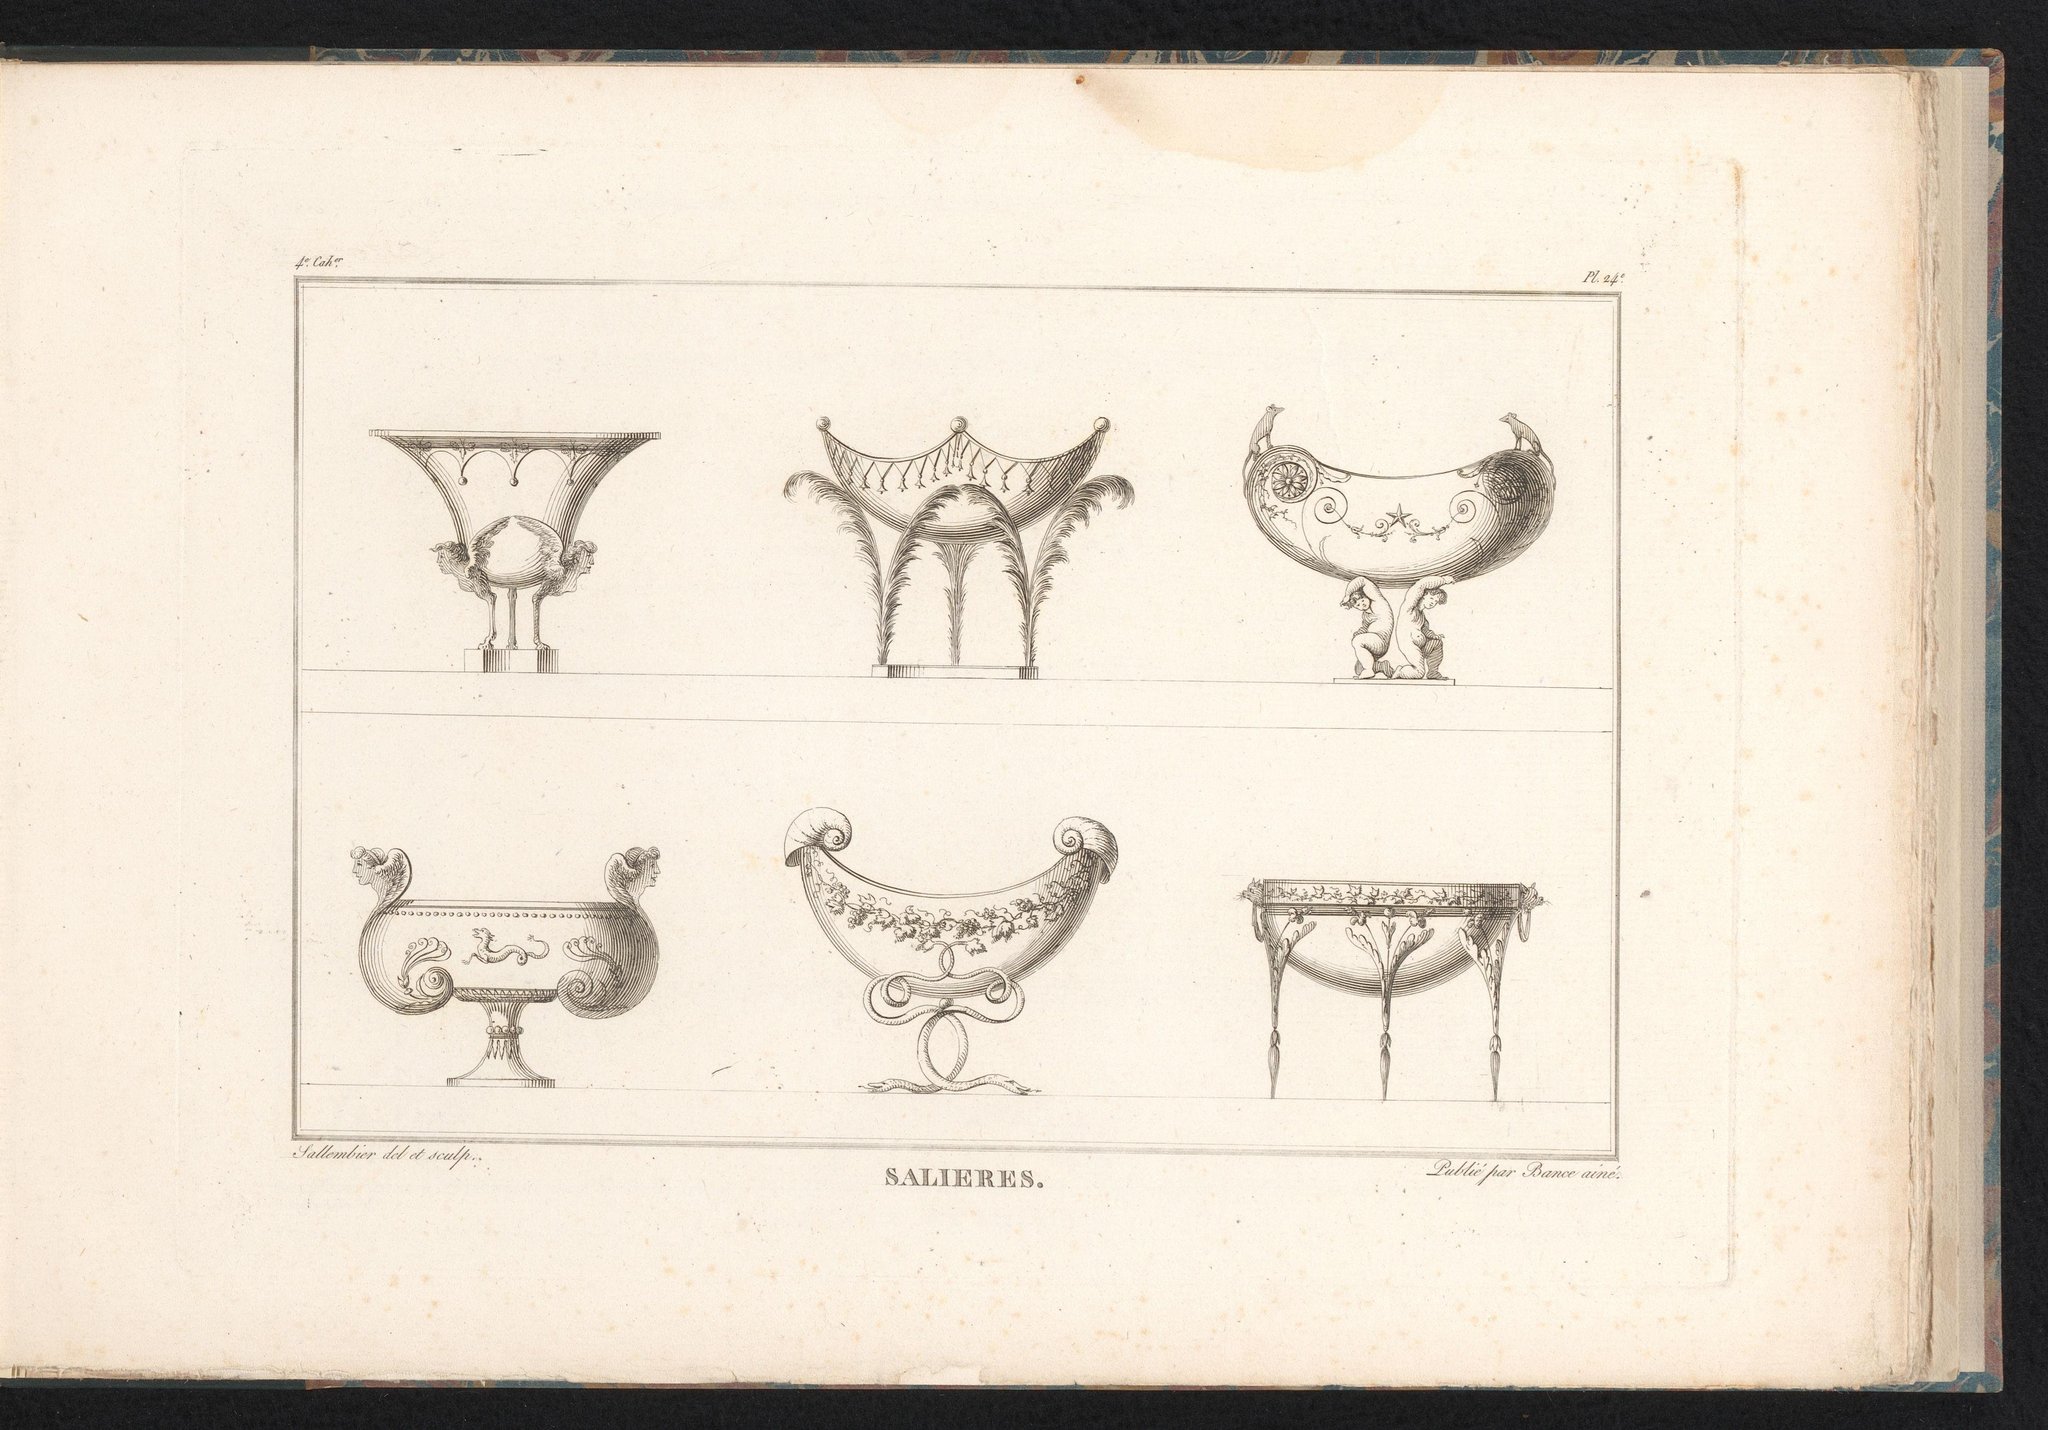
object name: album leaf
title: Zoutvaten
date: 1805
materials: paper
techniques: etching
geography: paris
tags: foliage ~ ornament, cupids: 'amores', 'amoretti', 'putti', salt-cellar, salt-shaker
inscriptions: number: ‘4.e Cah.er’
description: Ontwerpen voor zes zoutvaten. Prent maakt deel uit van een album.